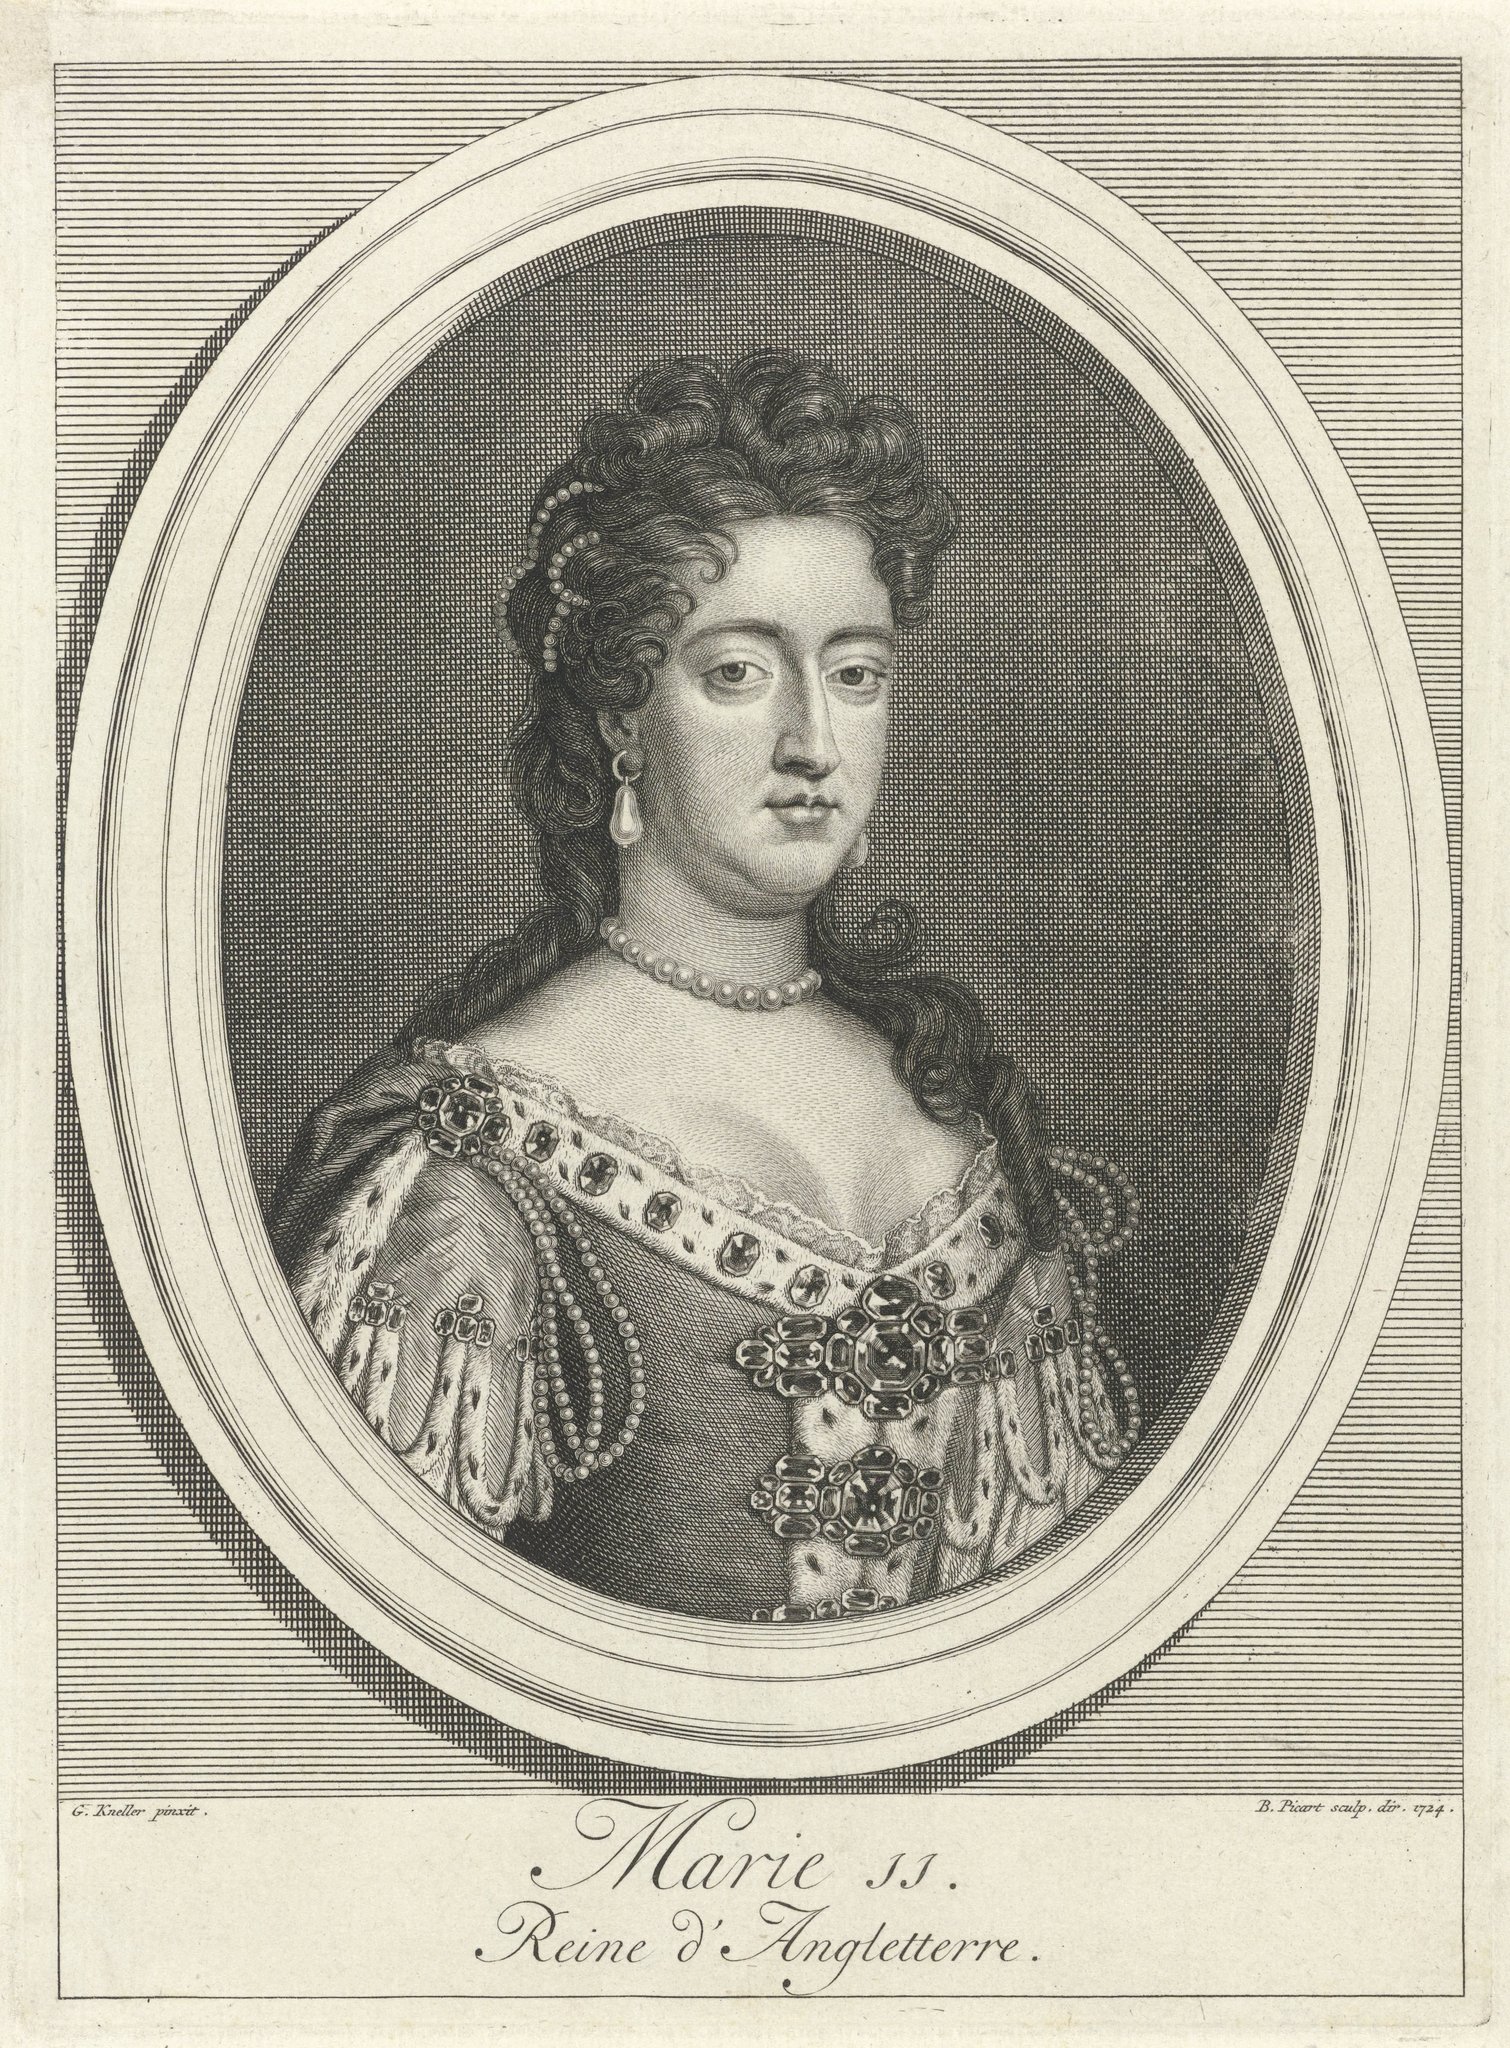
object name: print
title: Portret van Maria II Stuart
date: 1724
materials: paper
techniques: engraving, etching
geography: low countries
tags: london, maria ii stuart (koningin van engeland, schotland en ierland)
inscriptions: date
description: Portret van Maria II in een ovaal. In de ondermarge haar naam en titel in het Frans.